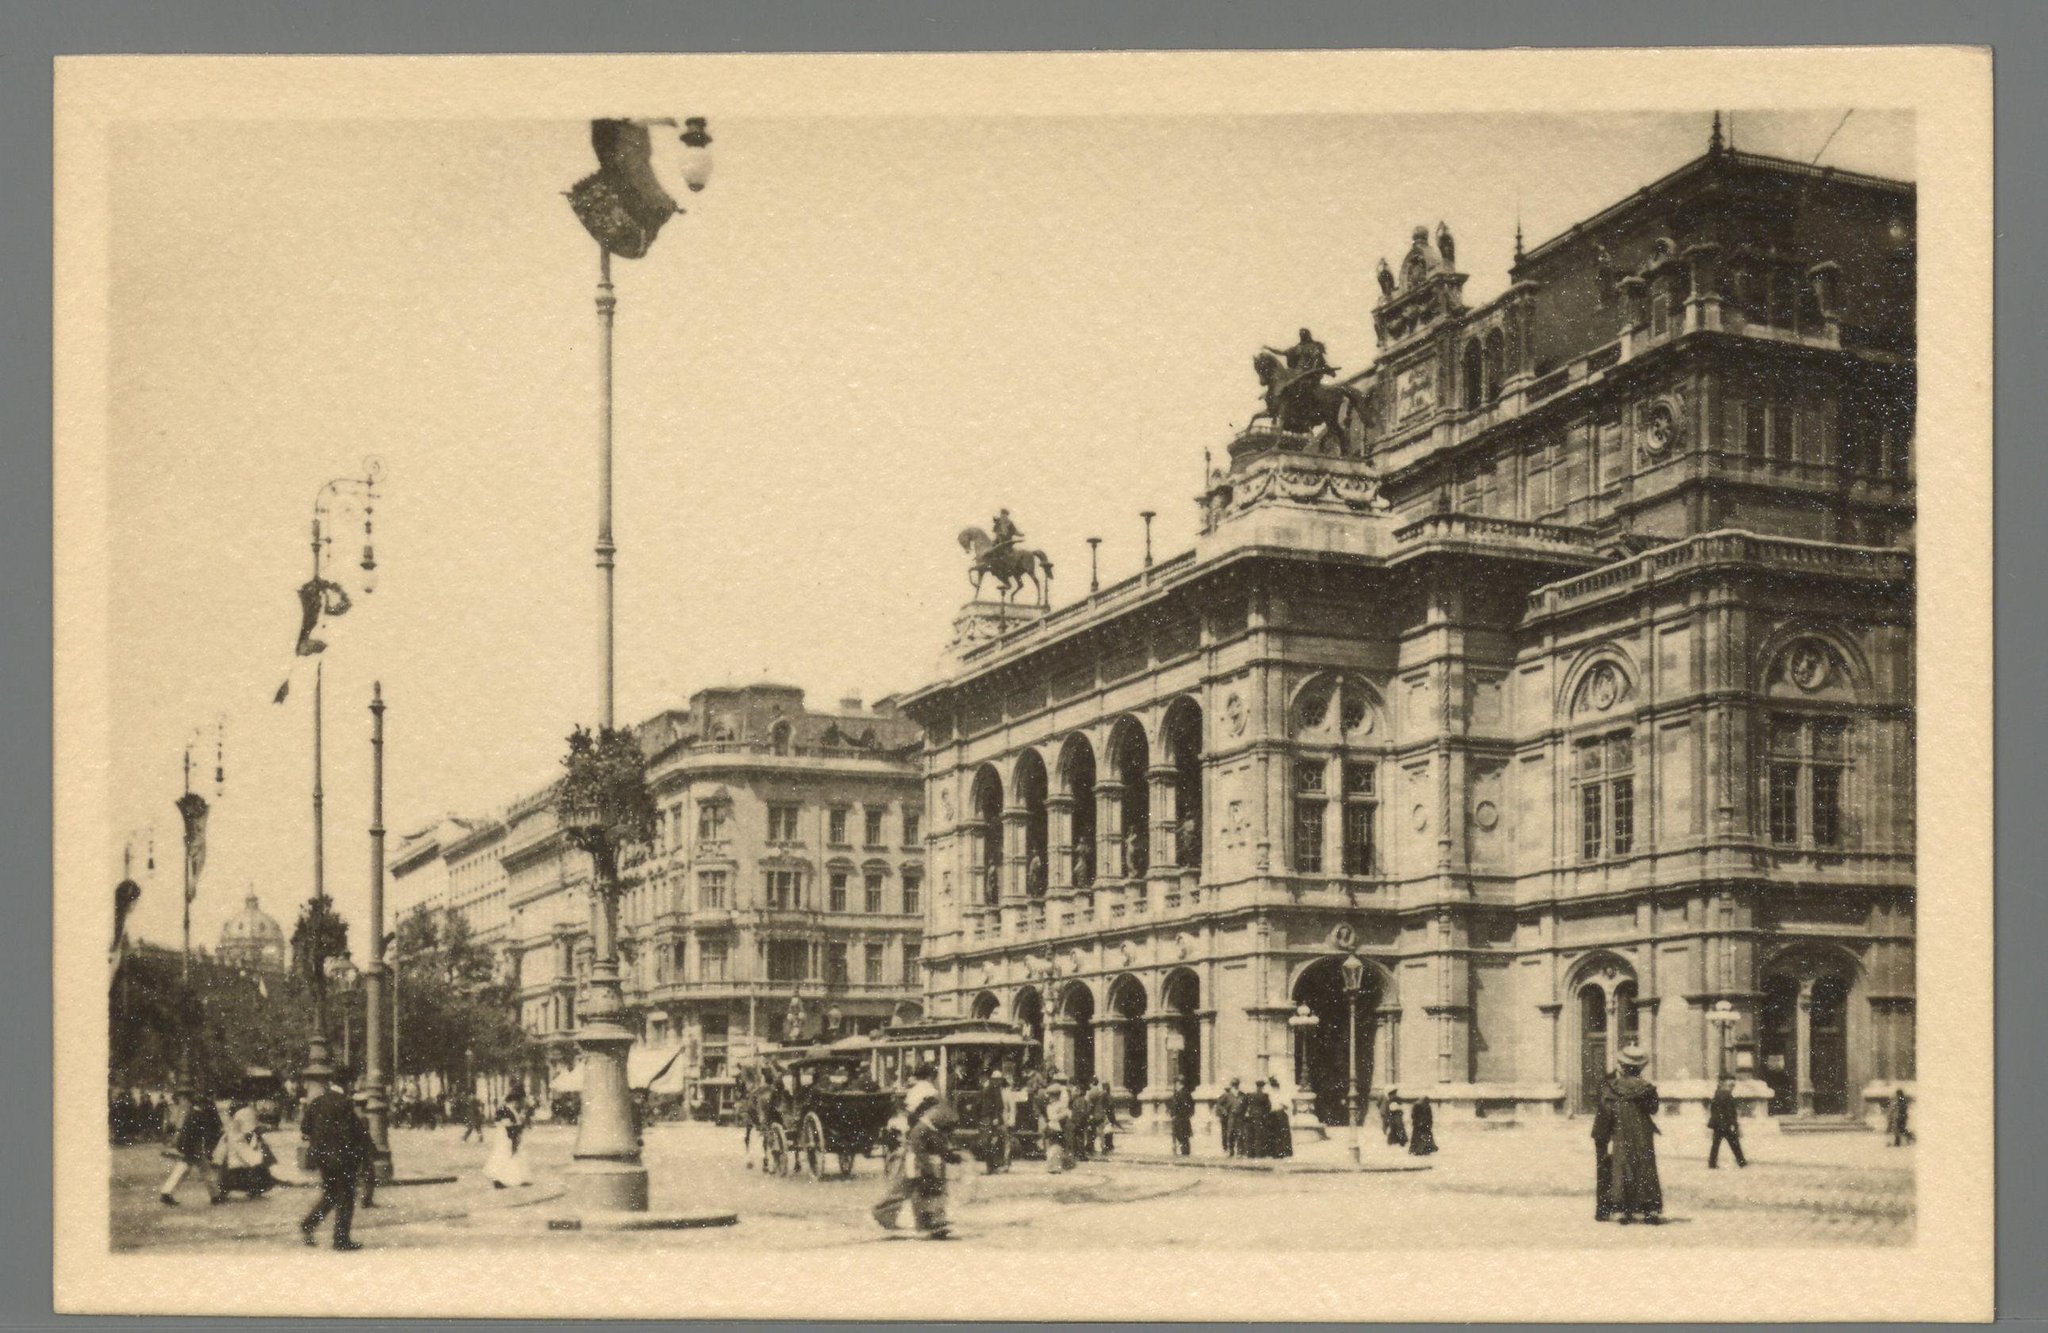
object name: photograph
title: Wien, k.k. Hofoper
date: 1904-1930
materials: paper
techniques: gelatin silver print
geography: vienna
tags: opera house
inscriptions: inscription: ‘K.L. Wien’